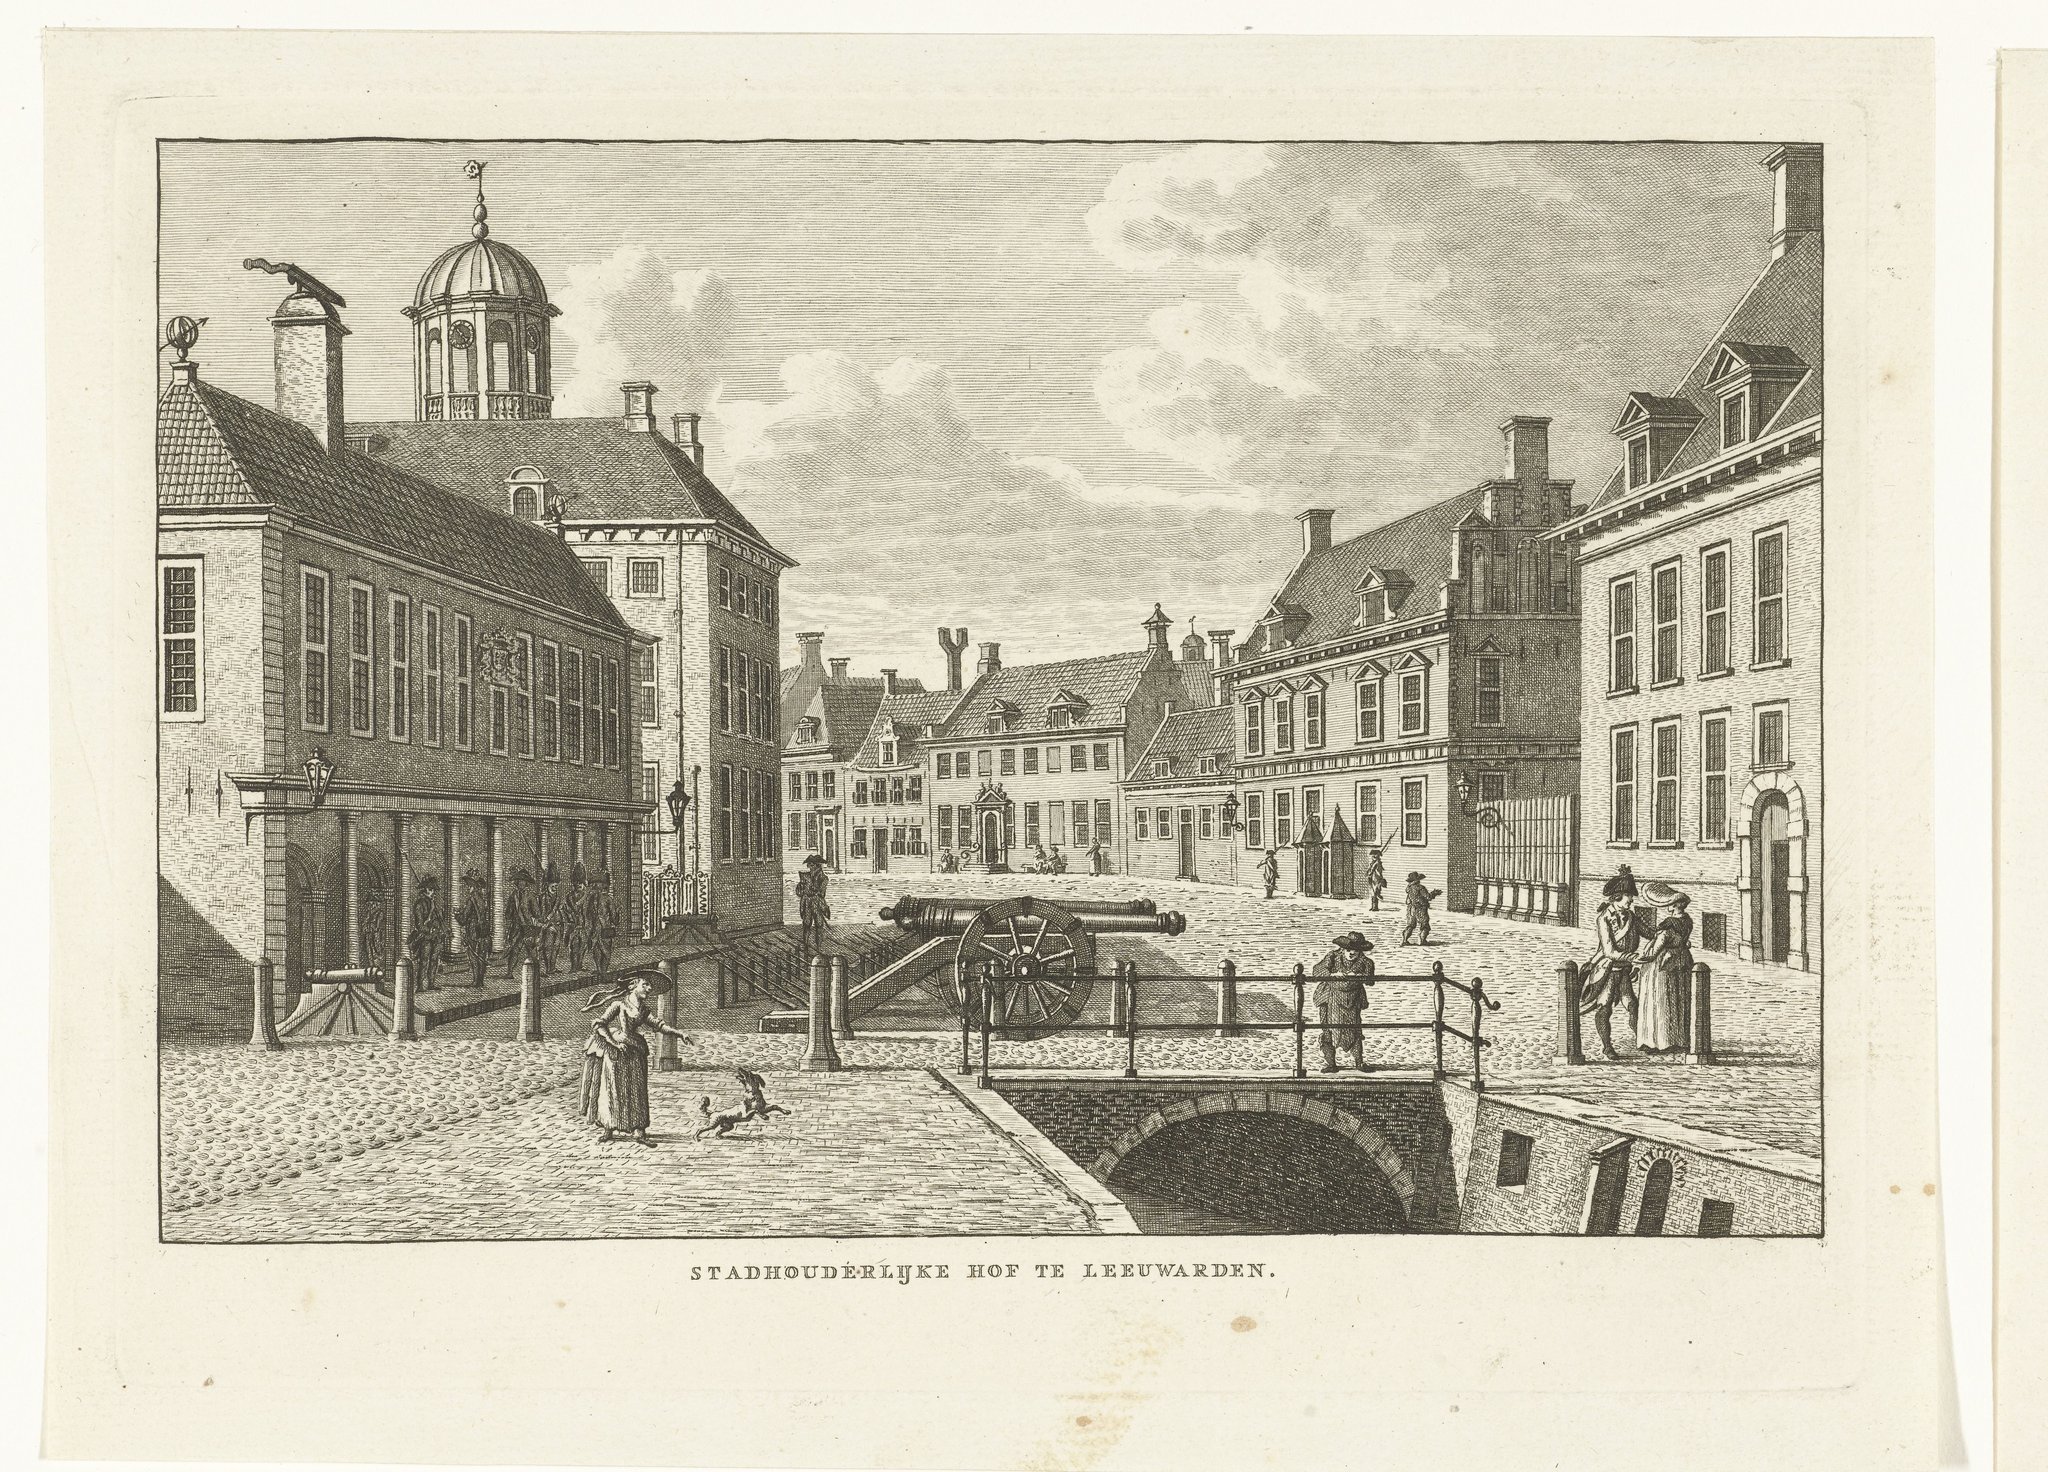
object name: print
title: Stadsgezicht met Stadhouderlijk Hof te Leeuwarden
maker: carel frederik bendorp (i)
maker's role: print maker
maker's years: 1736-1814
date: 1786-1792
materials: paper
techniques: etching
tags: city-view in general; 'veduta'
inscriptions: collector's mark: Lugt 2228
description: Prent uit: Vaderlandsche gezichten, of afbeeldingen van den tegenwoordigen staat der Vereenigde Nederlanden (…). Amsterdam: Hendrik Gartman, Willem Vermandel en Jan Willem Smit, 1786-1792. Uitgegeven in afleveringen met ieder een eigen bifolium en inhoudsopgave. Alle prenten in deze publicatie zijn gegraveerd door Carel Frederik Bendorp (I) en, in de meeste gevallen, gebaseerd op tekeningen van Jan Bulthuis.